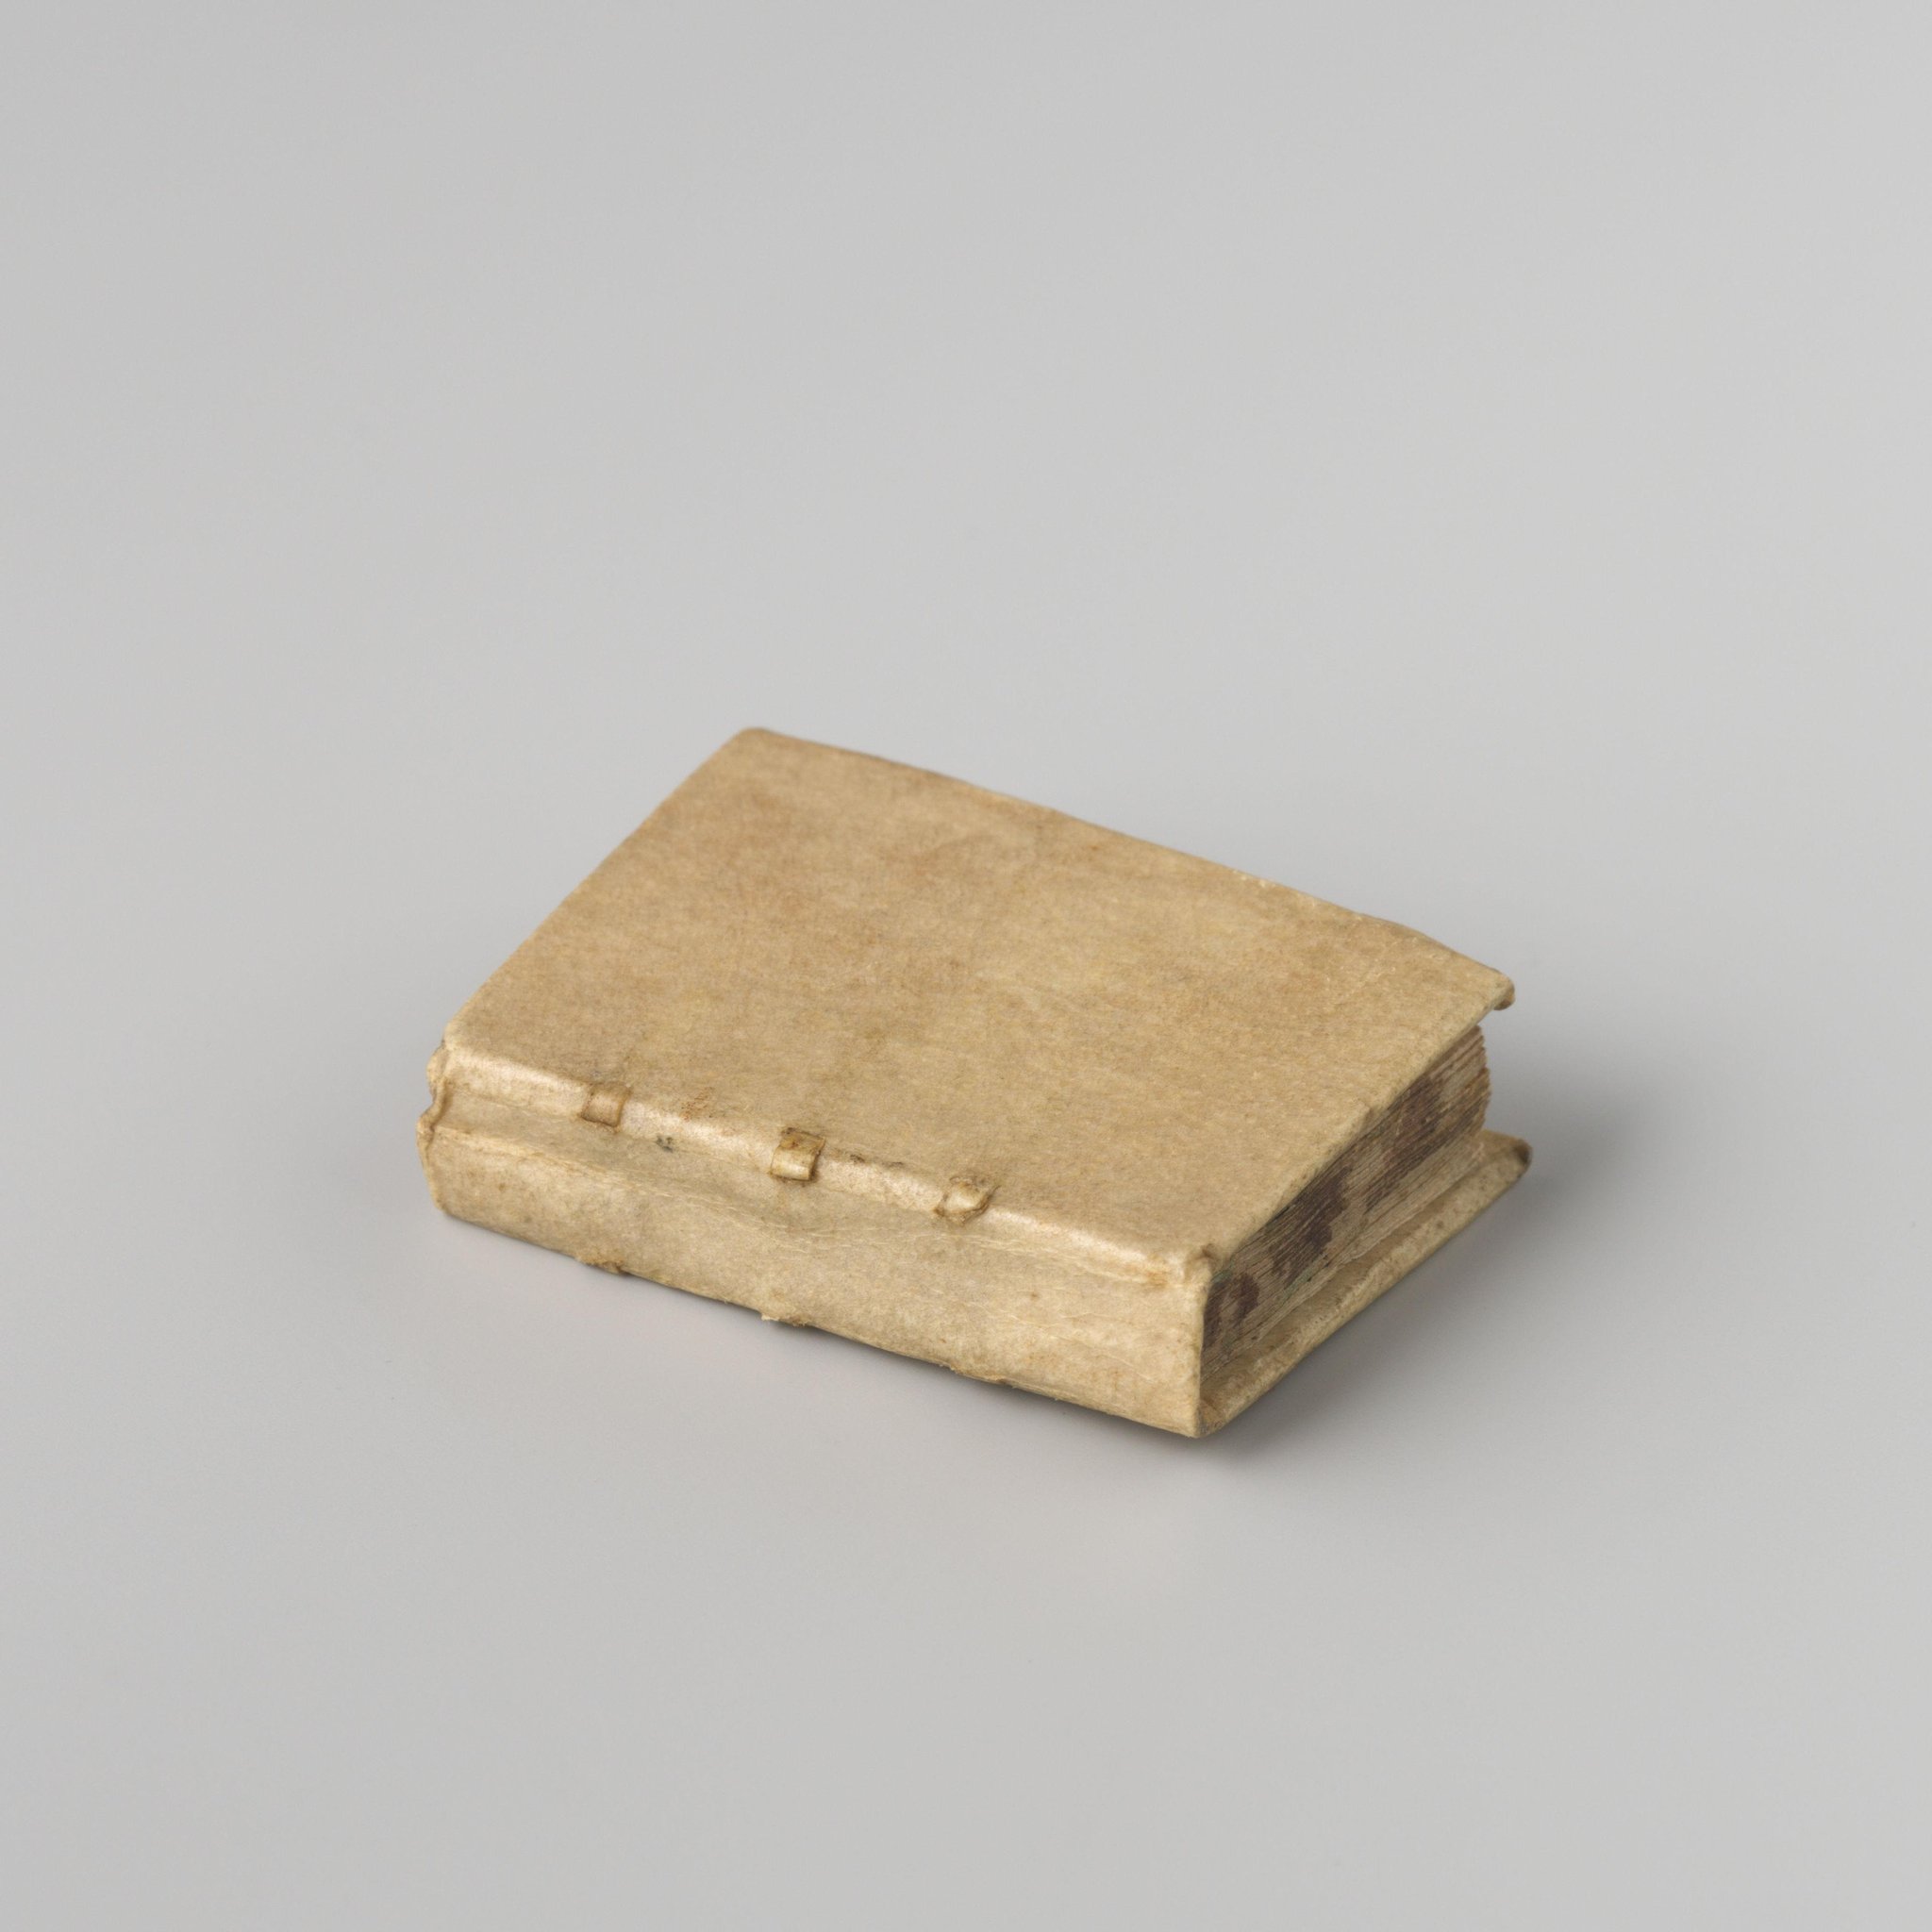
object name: album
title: Wapenboek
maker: jacobus robijn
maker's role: print maker, publisher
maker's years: -1707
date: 1673-1707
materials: paper, parchment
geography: amsterdam